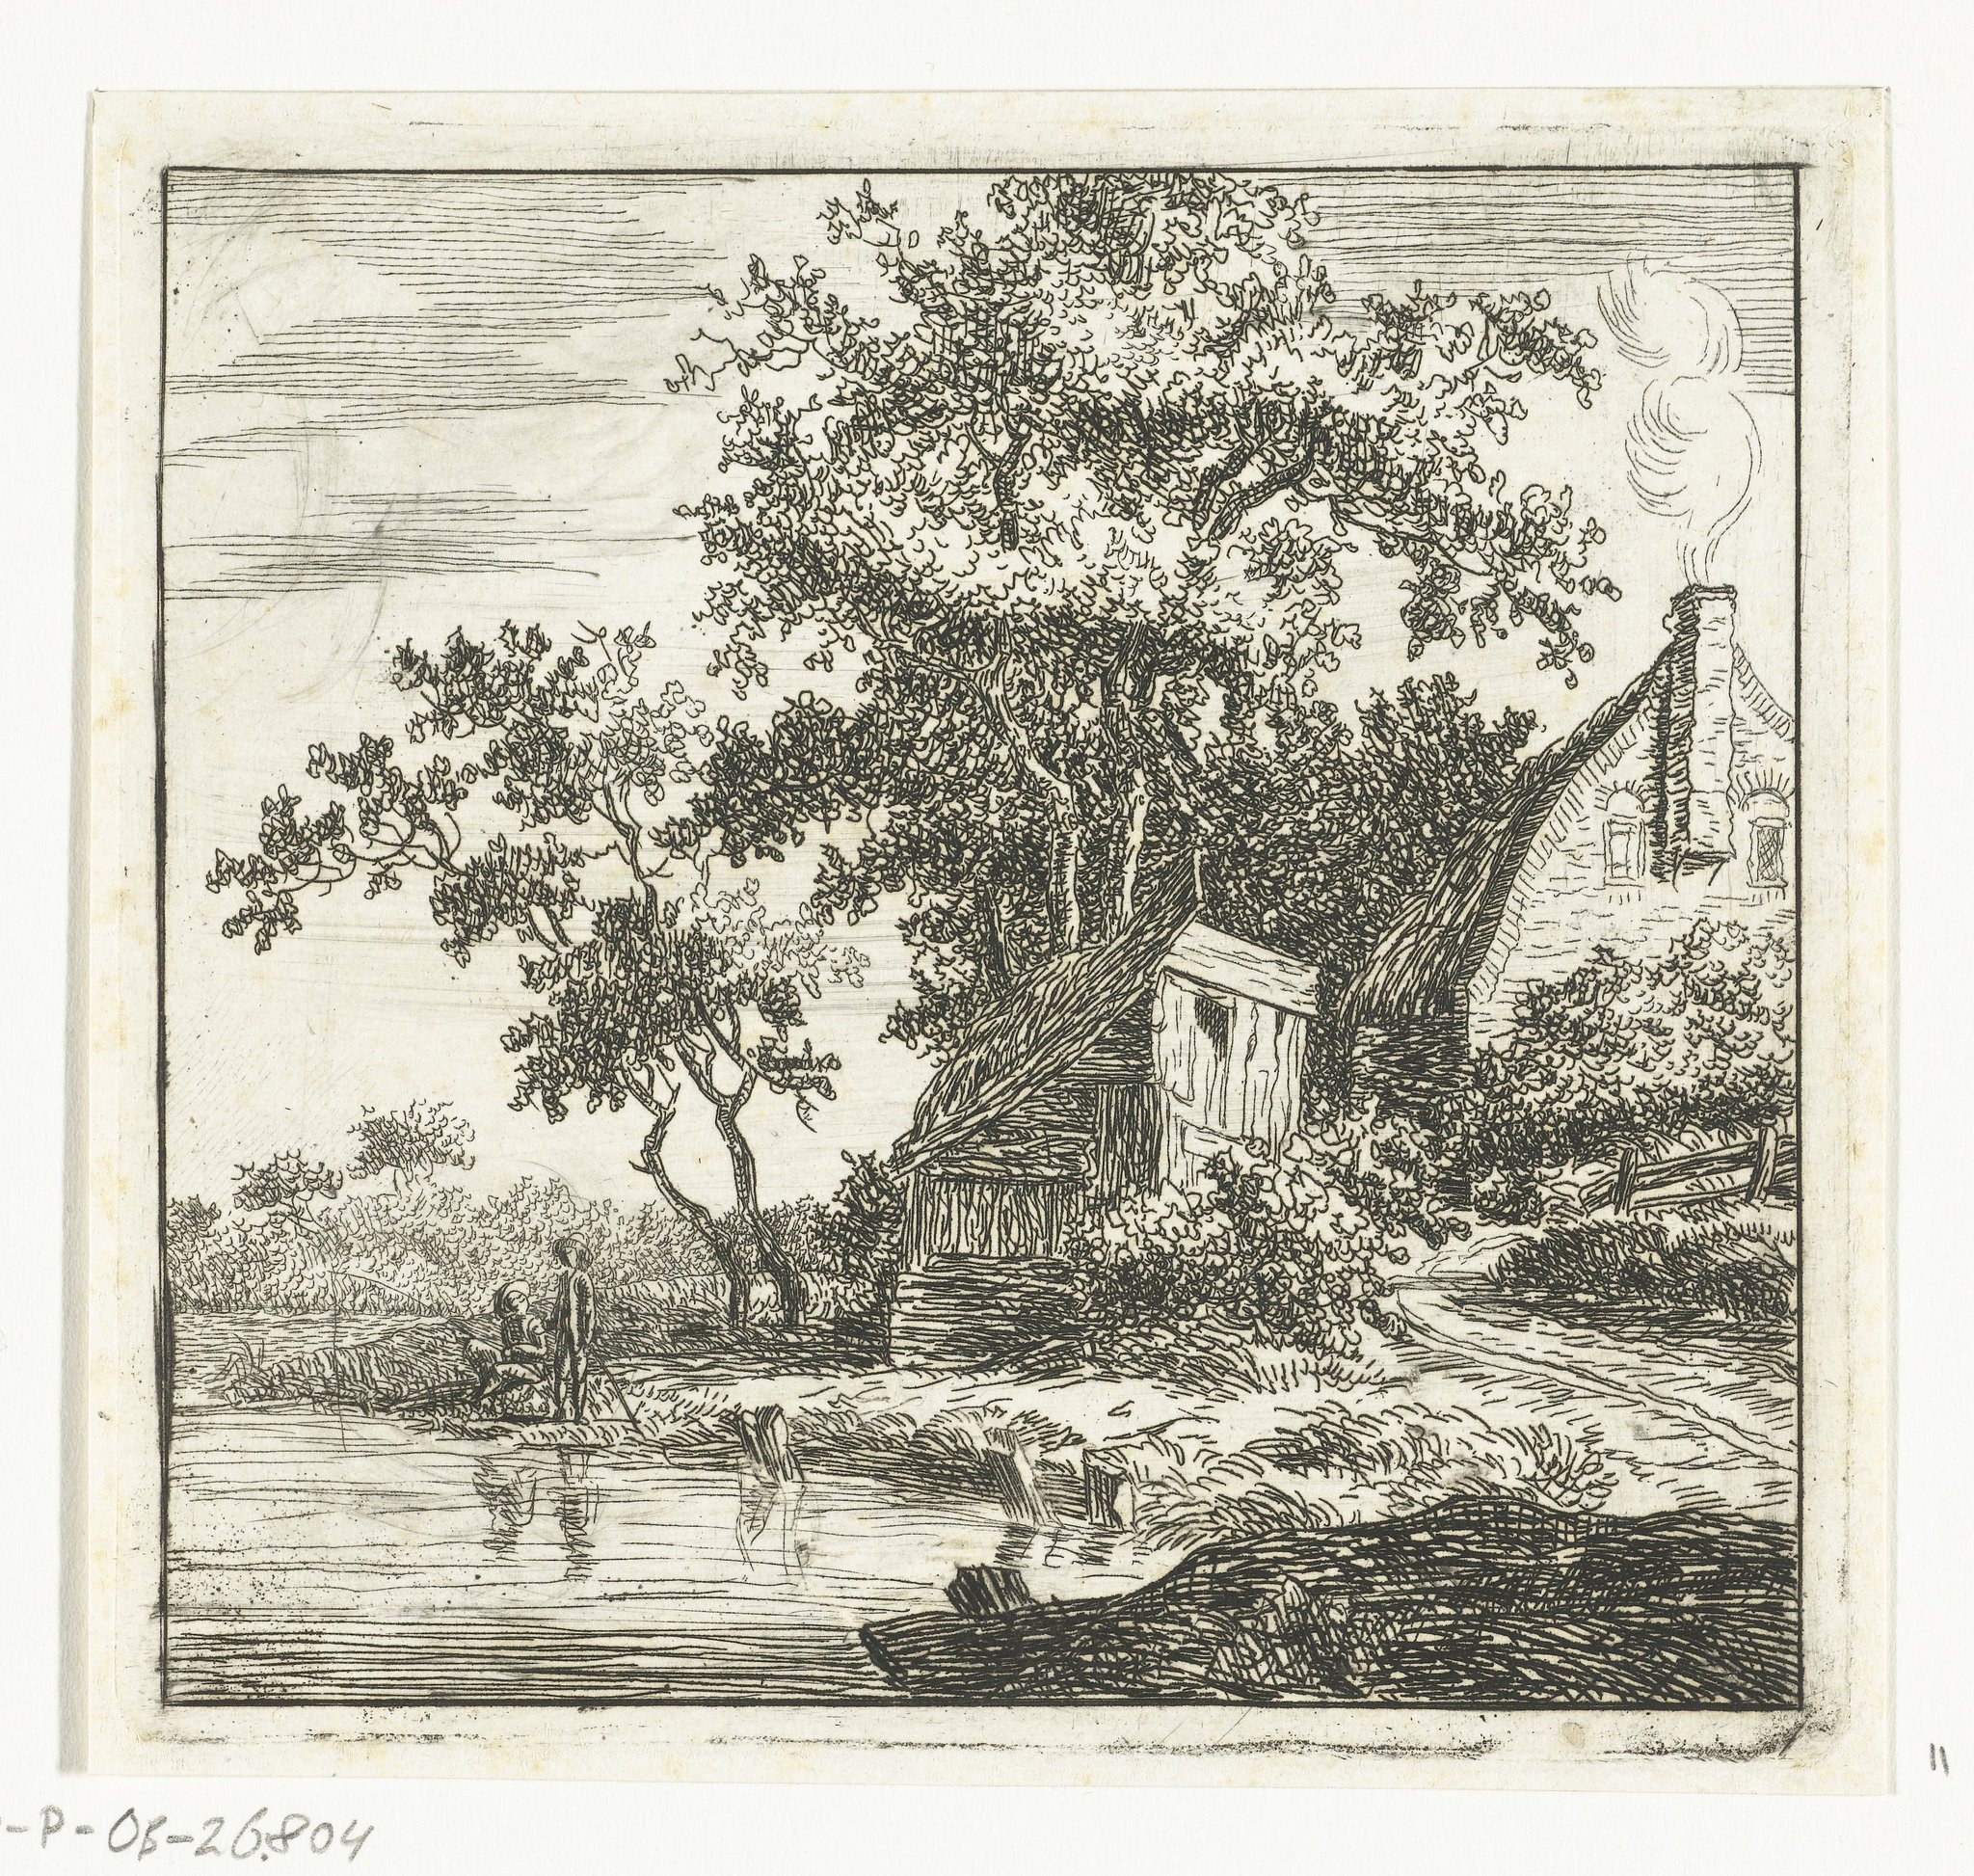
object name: print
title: Hengelaar bij schuurtje aan het water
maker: anthonie van den bos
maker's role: draughtsman, print maker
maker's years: 1763-1838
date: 1778-1838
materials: paper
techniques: etching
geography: netherlands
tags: angling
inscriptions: collector's mark: Lugt 2228